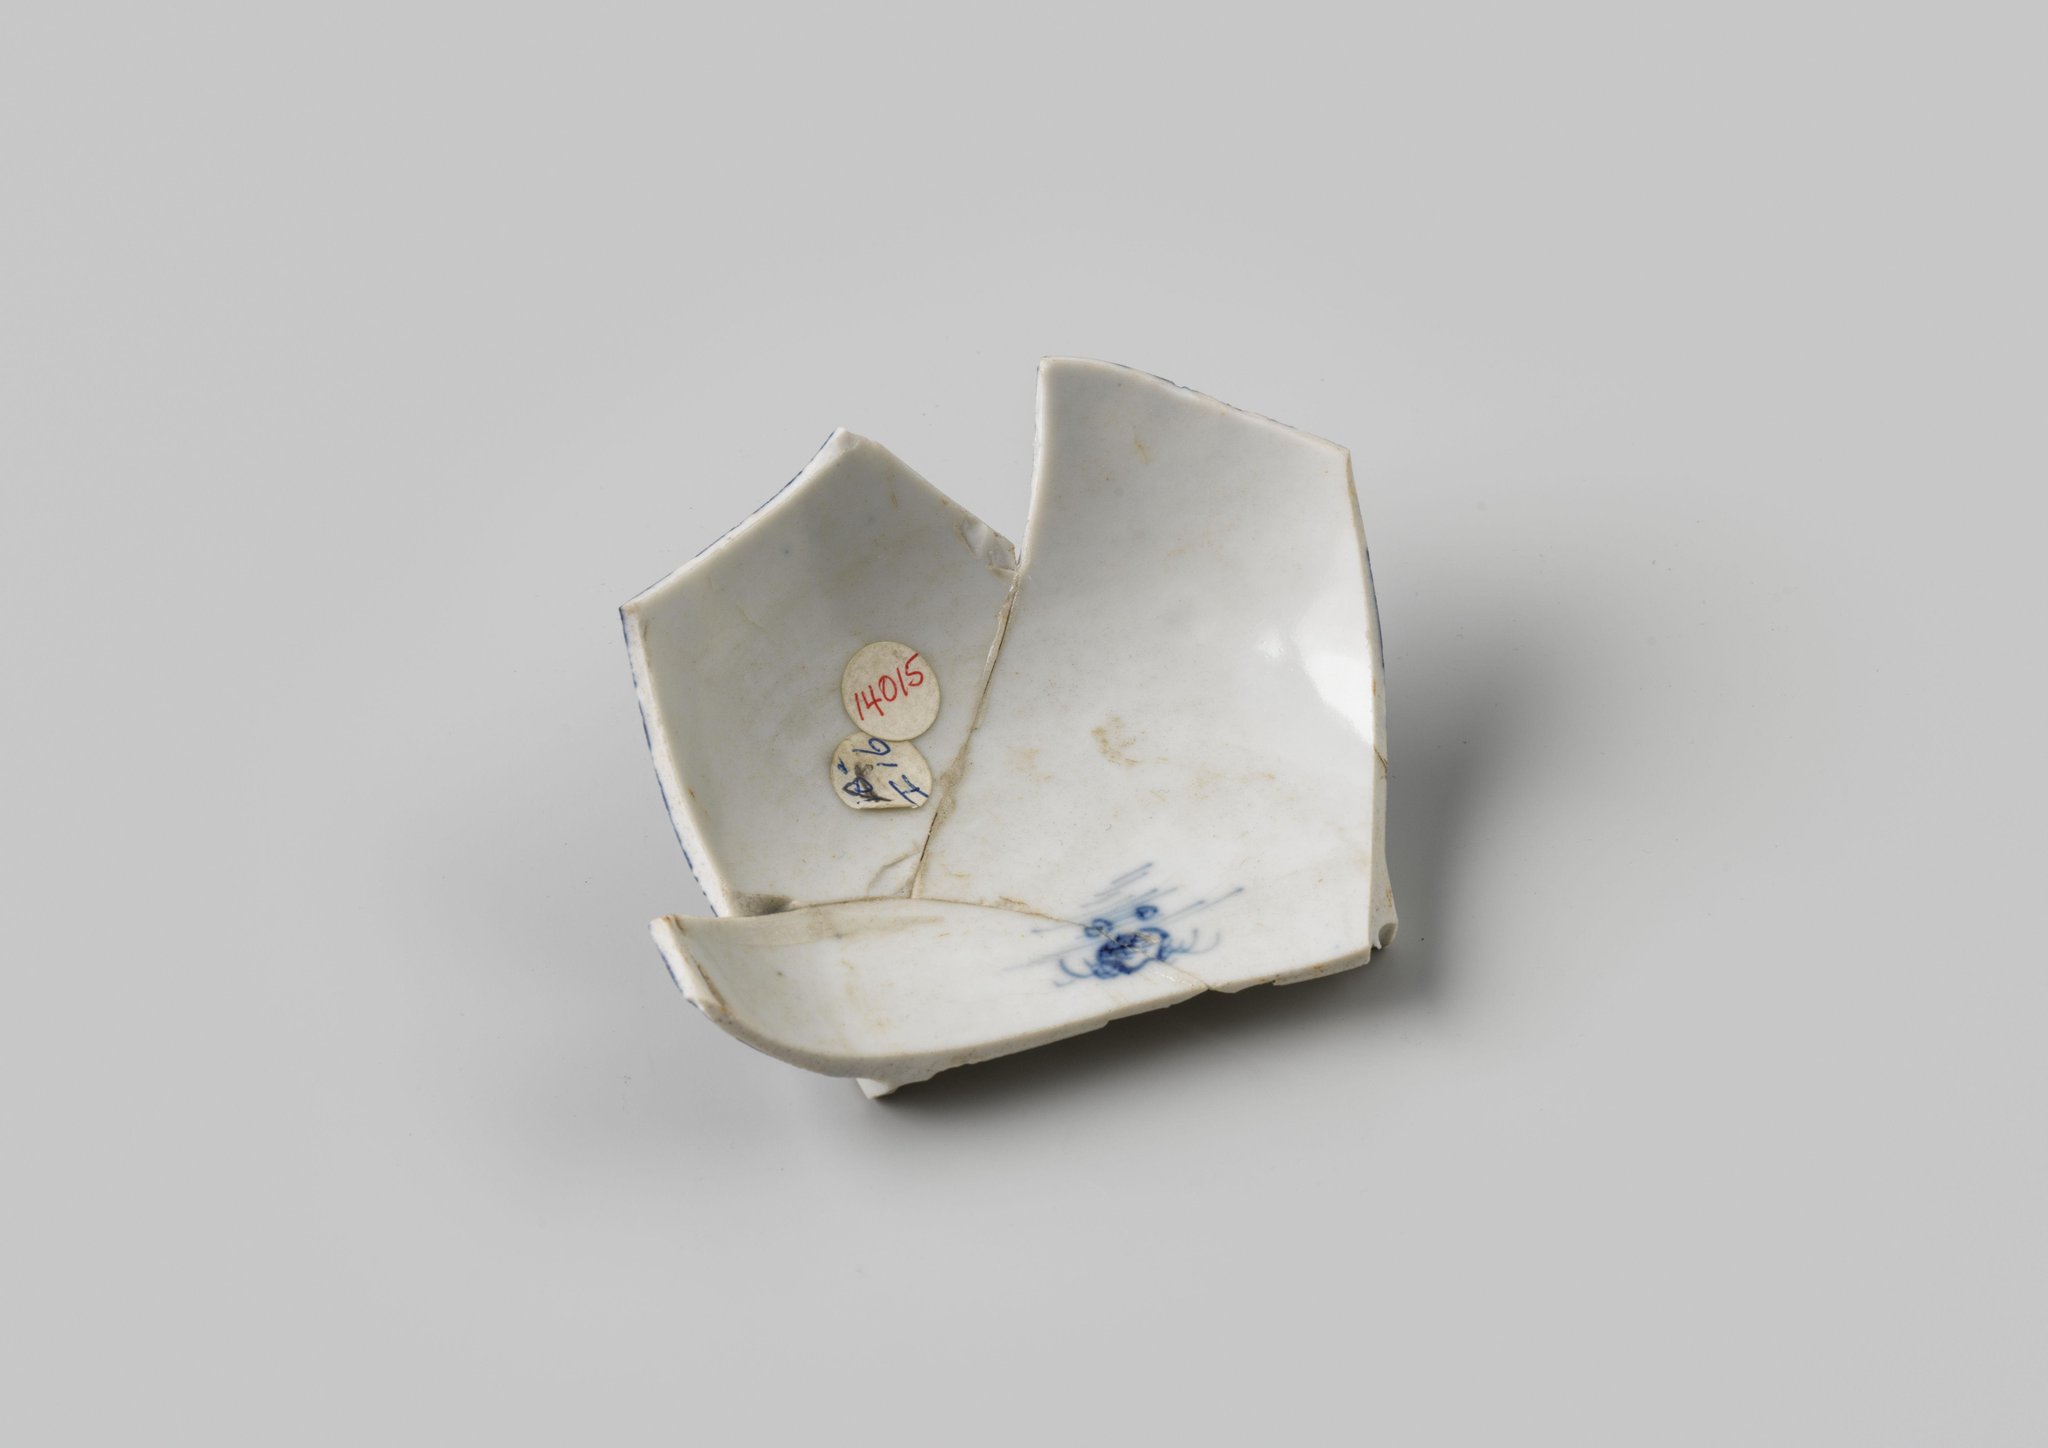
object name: bowl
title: Deel van servies, gevonden bij V.O.C.-schip Witte Leeuw, mogelijk afkomstig van Zeelelie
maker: Anonymous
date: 1775-1800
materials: porcelain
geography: jingdezhen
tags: verenigde oostindische compagnie, sint-helena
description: Kom. Deel van servies gemaakt voor export naar Anglo-Saxische landen, 25% aanwezig. Drie aan elkaar gelijmde fragmenten. Dit object is 18e-eeuws en kan dus niet van de vracht van de Witte Leeuw zijn. Onduidelijk is of het object van de site komt of dat het later is vermengd, mogelijk met materiaal van de Zeelelie.